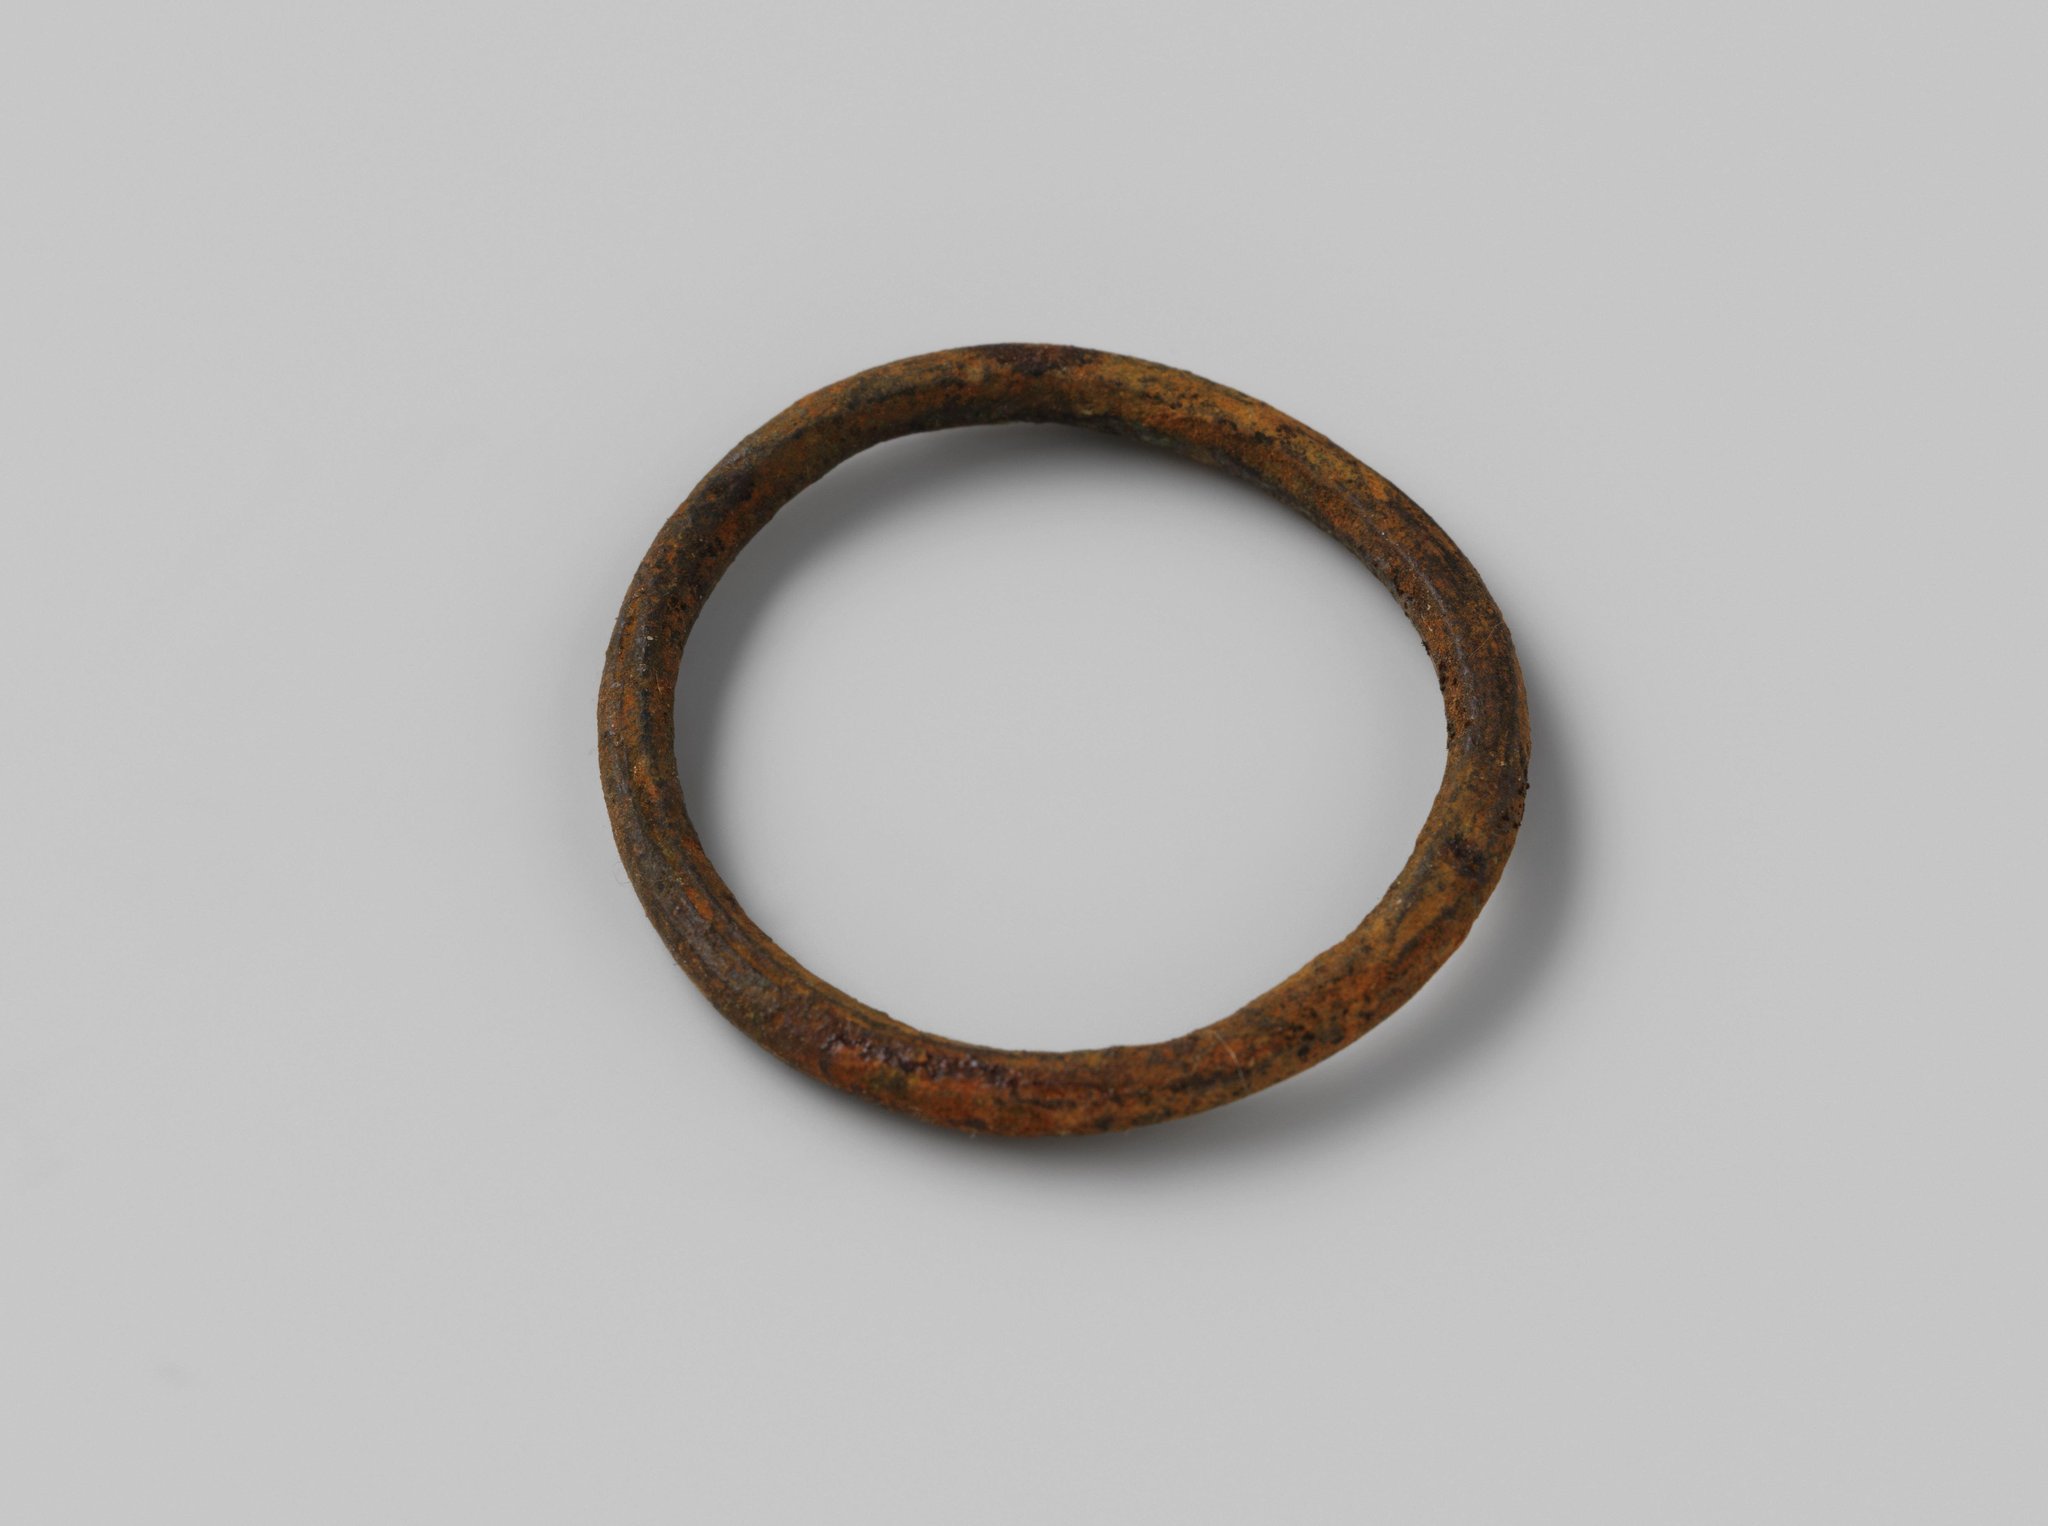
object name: fragment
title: Ringvormig fragment uit het wrak van de Oost-Indiëvaarder Hollandia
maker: Anonymous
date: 1700-1743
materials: copper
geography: netherlands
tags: verenigde oostindische compagnie, hollandia (schip), annet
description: Varied parts or fragments, rings or ring-shaped fragments; id. 80H946.